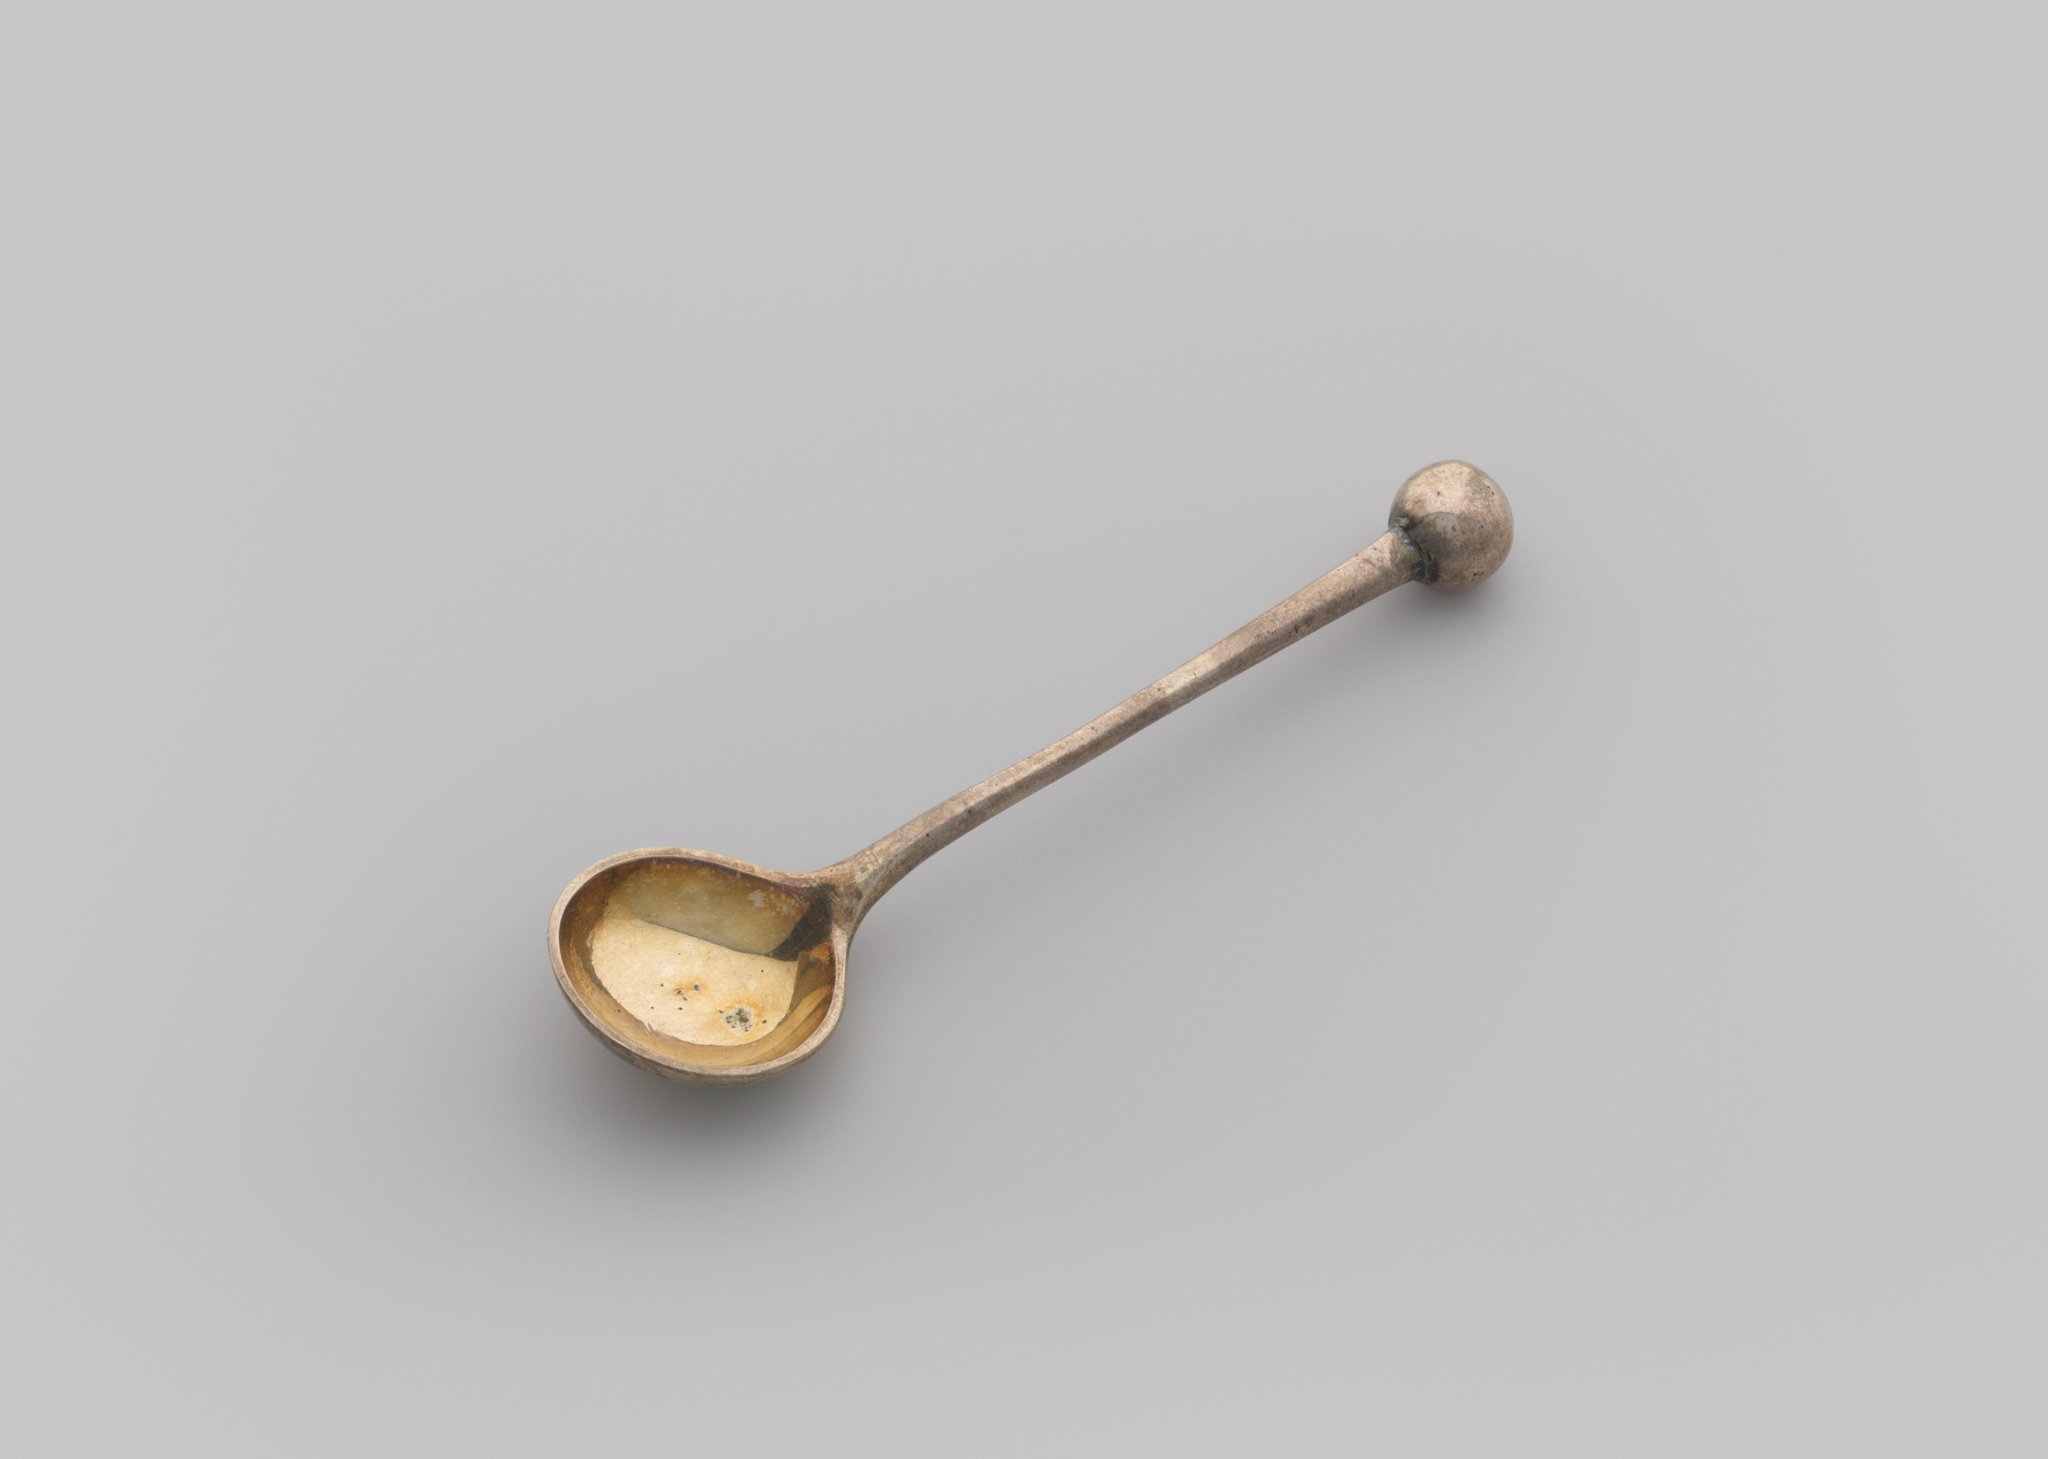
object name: spoon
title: Zoutlepel met ronde bak en ronde steel met bolbekroning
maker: Anonymous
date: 1800-1900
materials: silver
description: Zoutlepel van zilver met een ronde bak en ronde steel met bolbekroning.